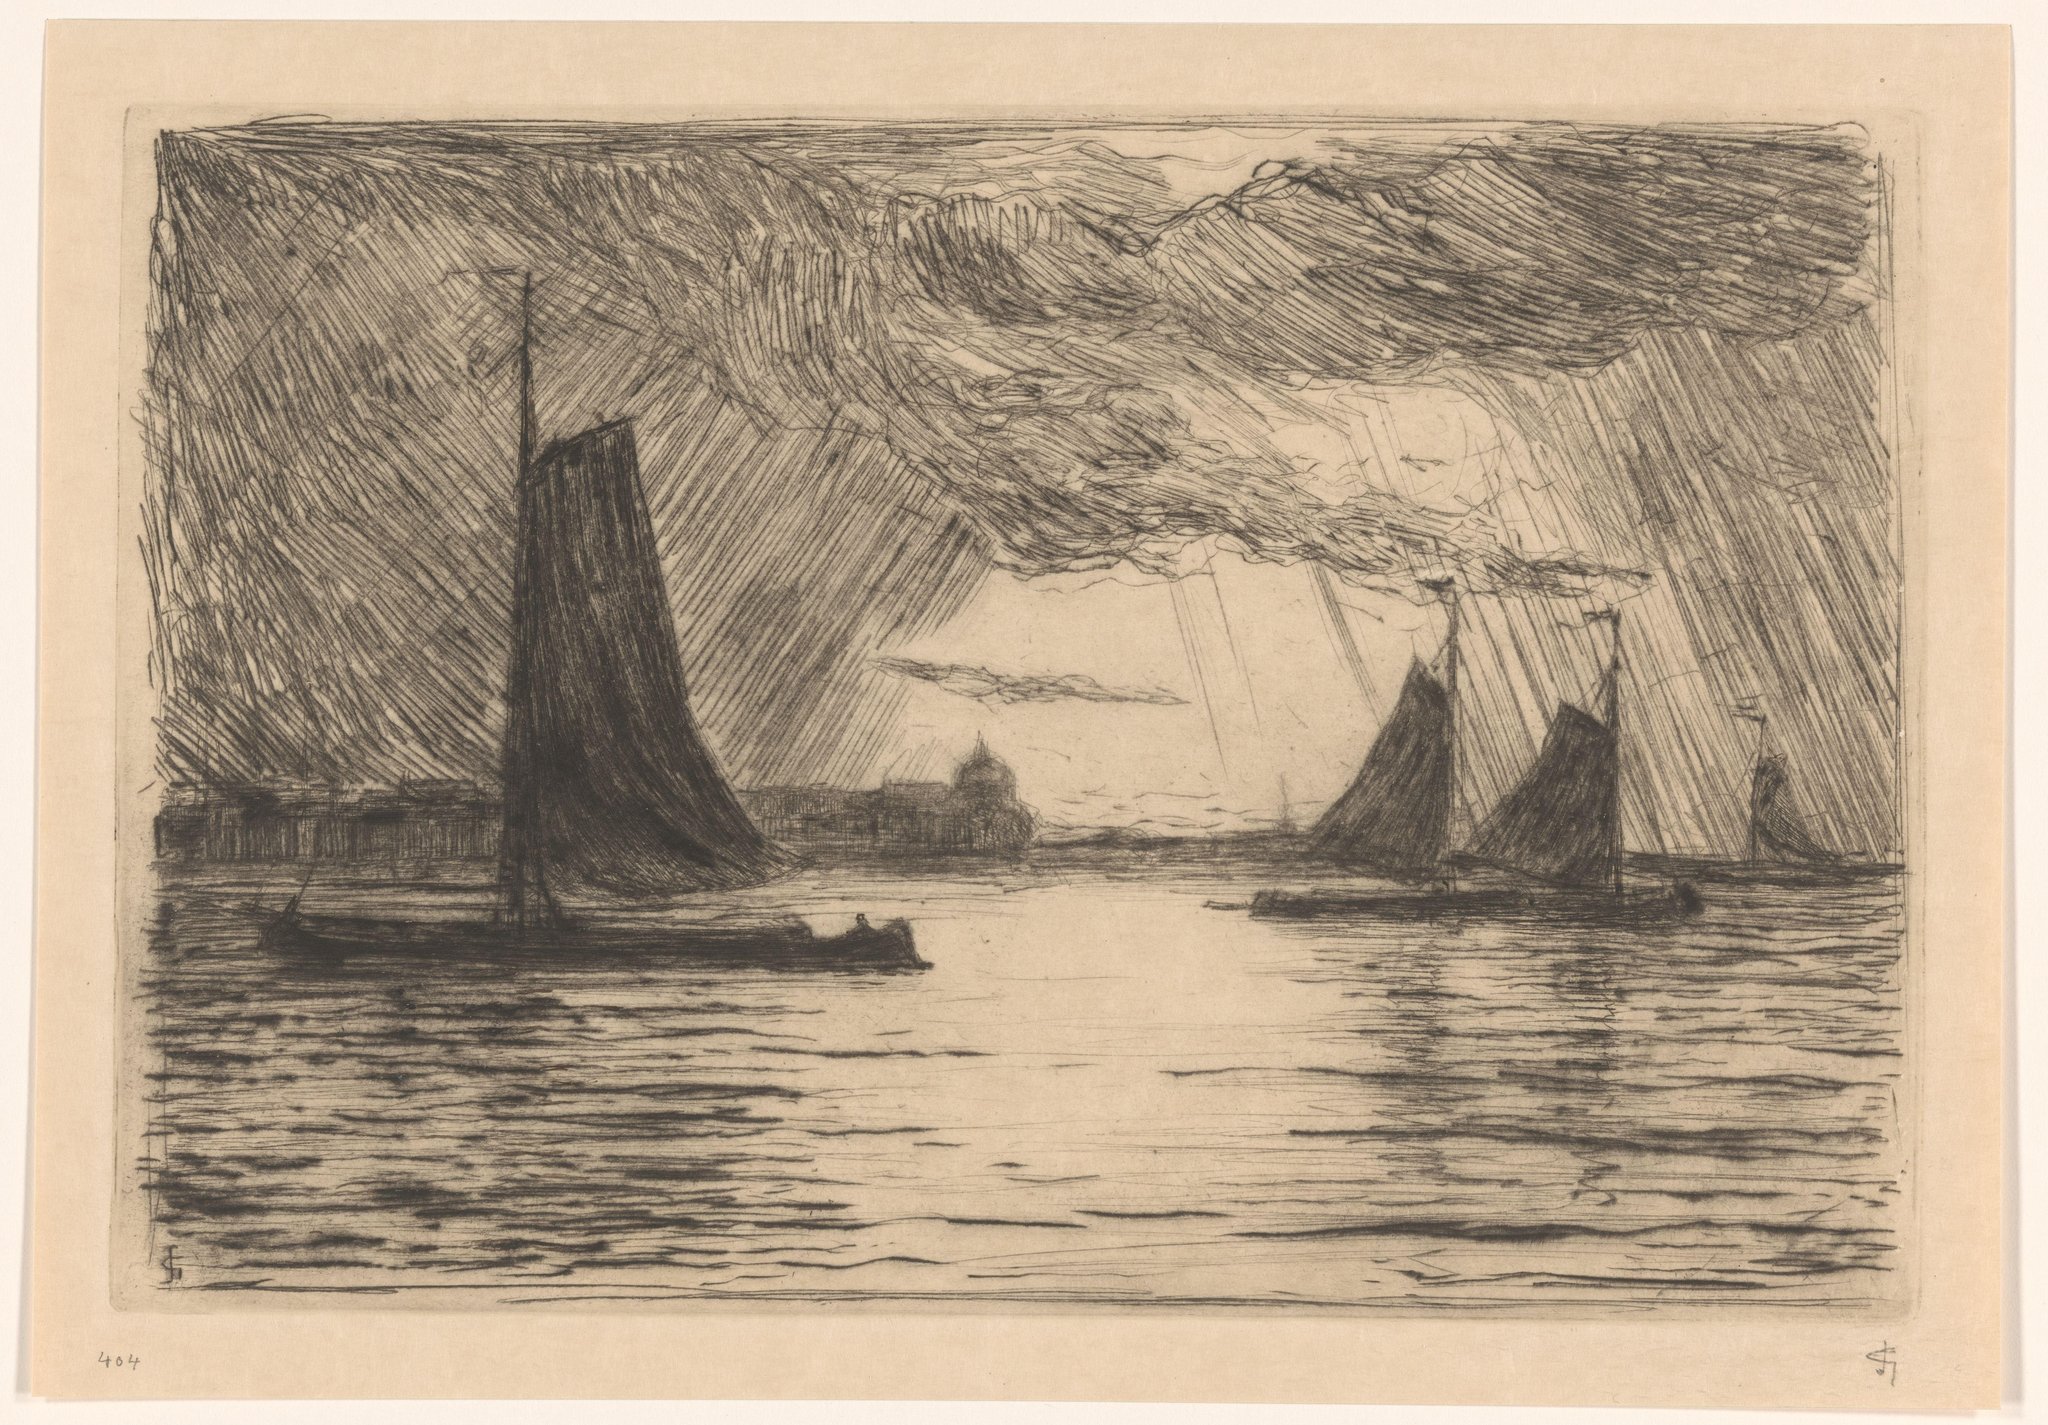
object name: print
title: Gezicht op de Maas bij Dordrecht bij avond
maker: carel nicolaas storm van s-gravesande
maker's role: draughtsman, print maker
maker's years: 1841-1924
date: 1851-1902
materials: paper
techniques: drypoint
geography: netherlands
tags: river, evening, prospect of city, town panorama, silhouette of city, dordrecht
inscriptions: number: ‘404’, collector's mark: Lugt 2228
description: Mogelijk vermeld in: Storm van 's-Gravesande, Charles. Catalogue des eaux-fortes et lithographies. New York: s.n., 1903, of in een onbekende latere uitgave van het manuscript. Vermoedelijk vermeld als catalogusnummer 404.